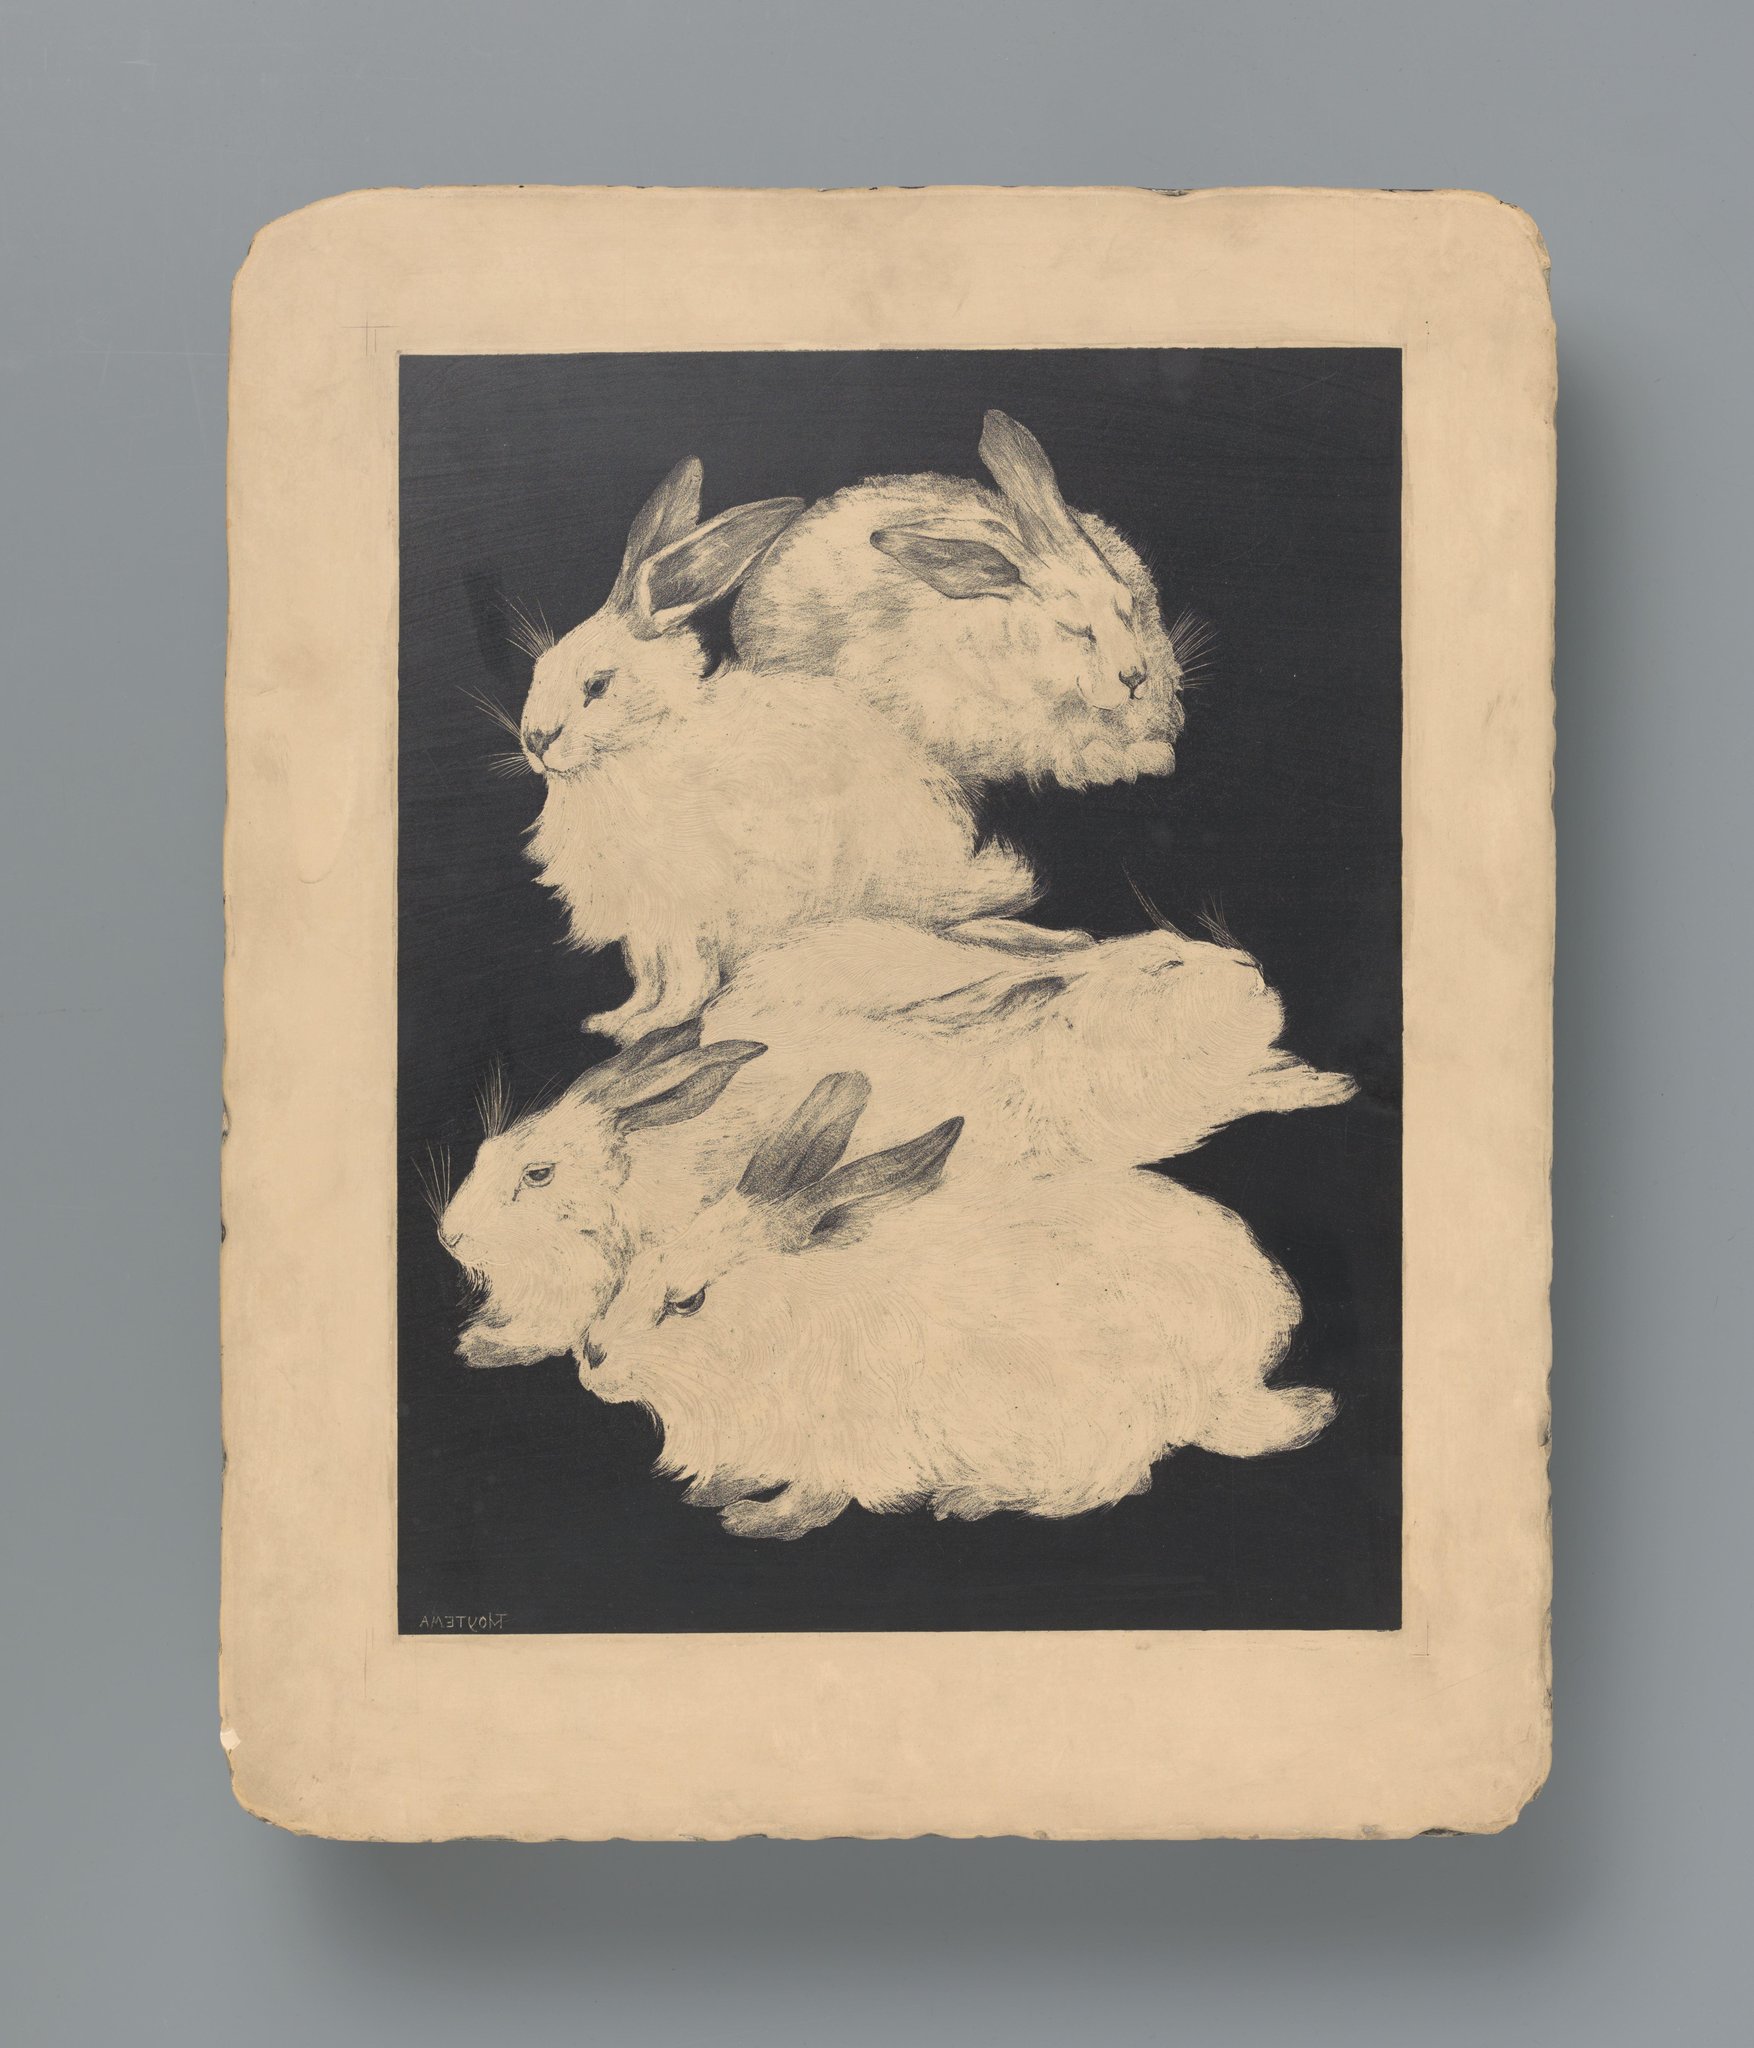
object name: lithographic stone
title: Vijf angorakonijnen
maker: theo van hoytema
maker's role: draughtsman, painter, print maker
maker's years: 1863-1917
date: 1873-1917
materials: stone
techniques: blind stamped, lithograph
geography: netherlands